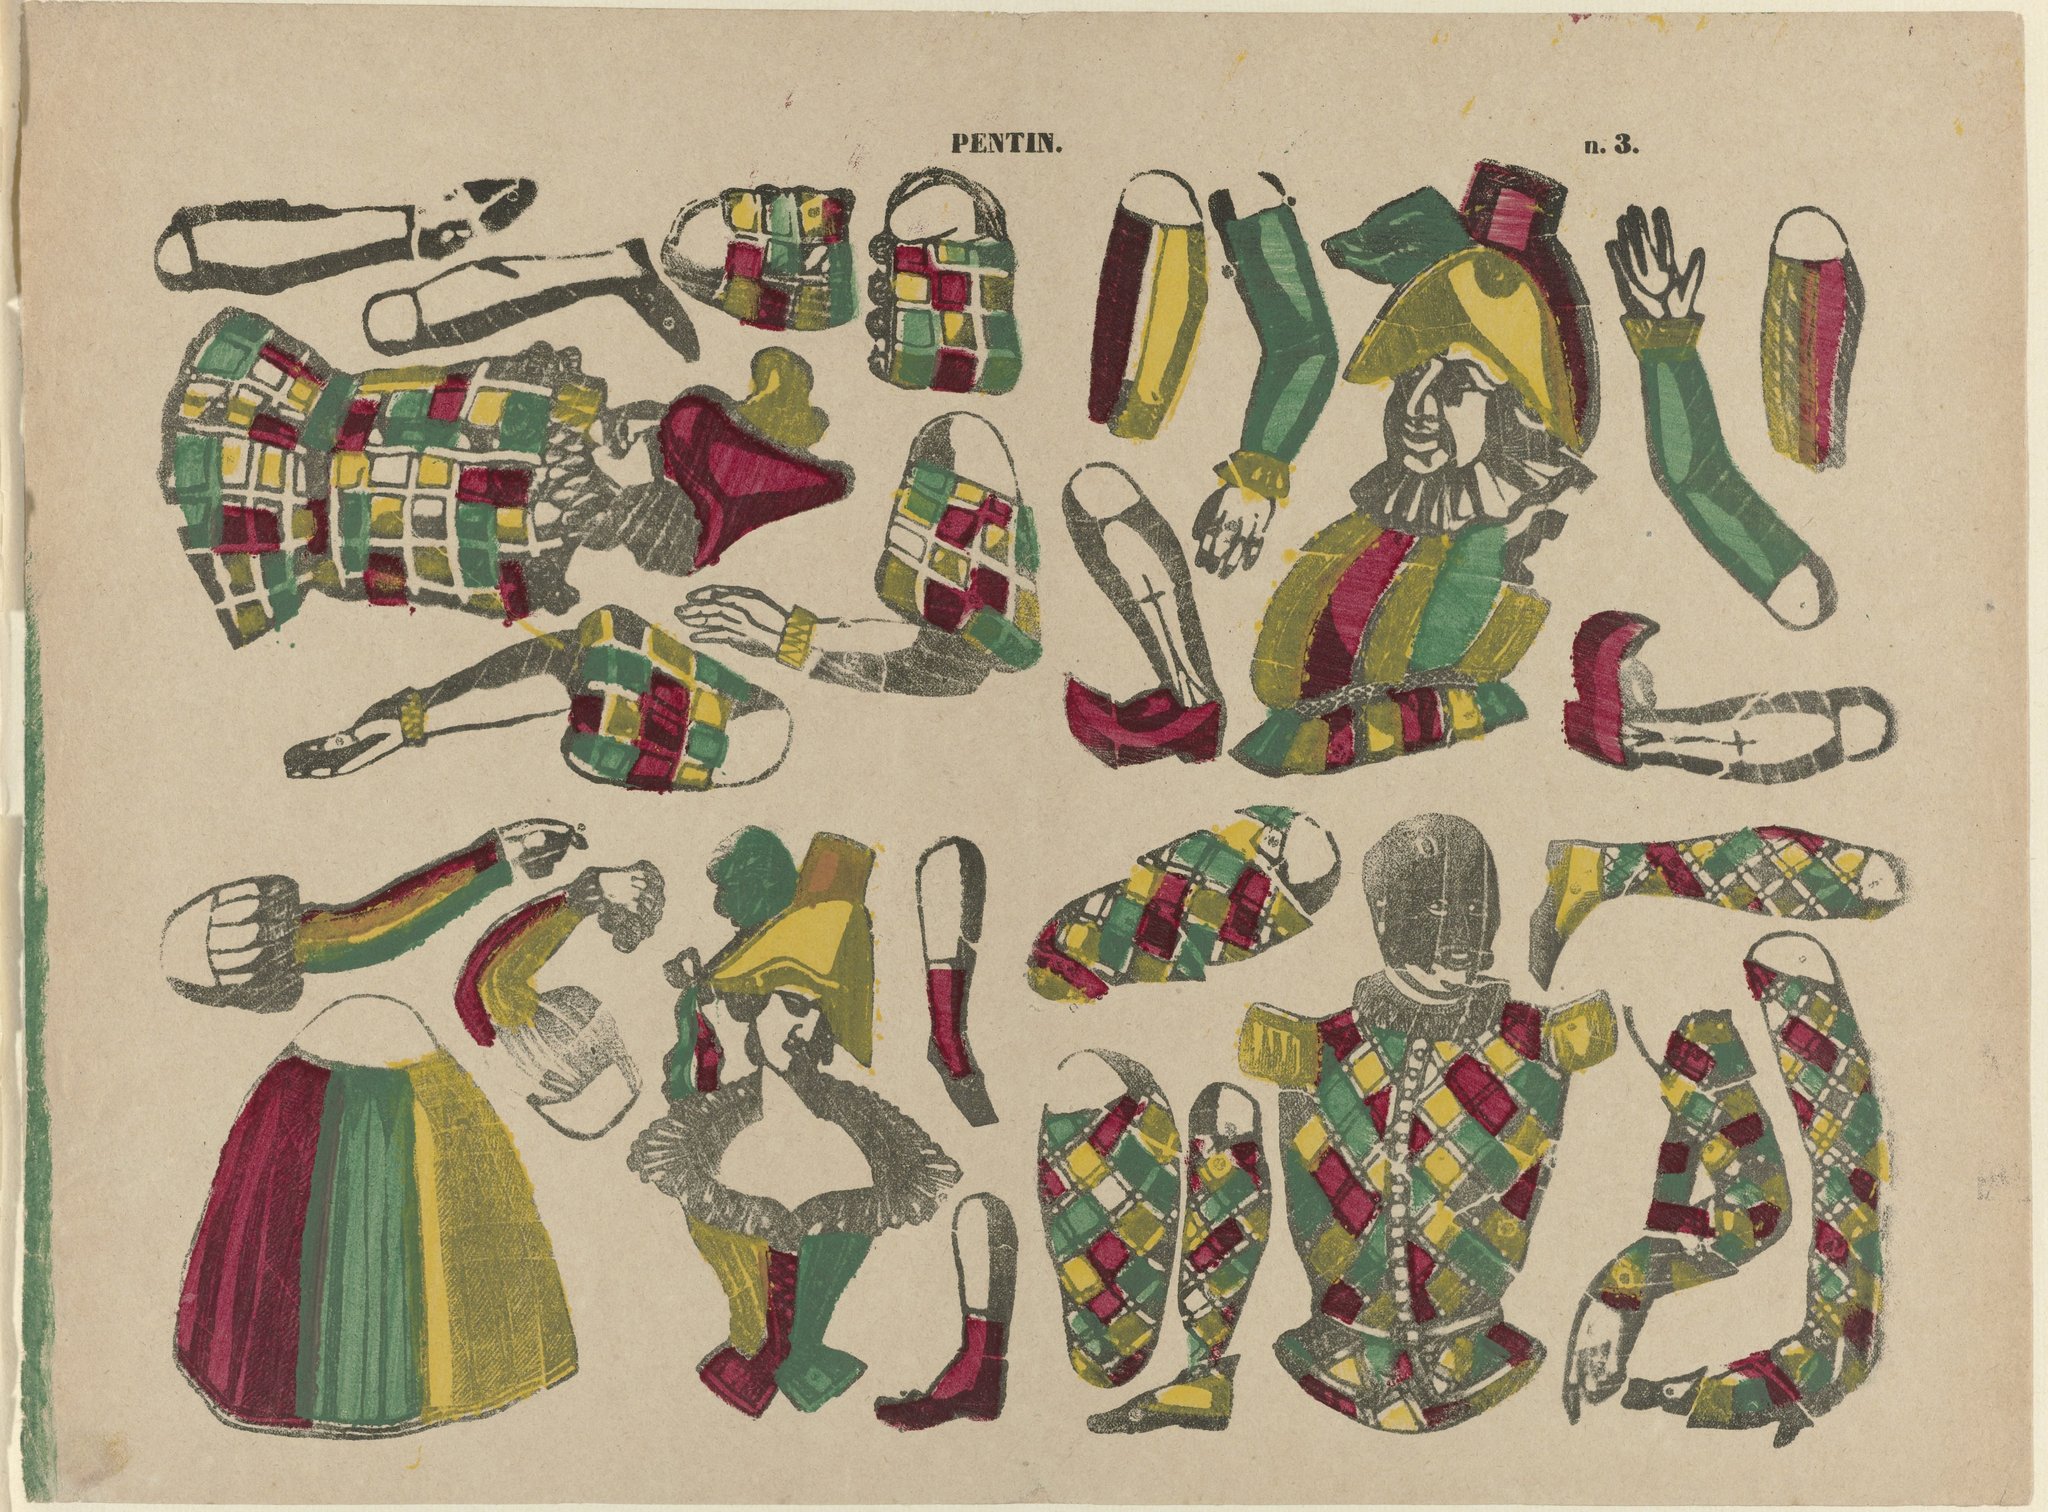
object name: pantin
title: Pentin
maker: Anonymous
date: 1856-1900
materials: paper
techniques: colour, letterpress printing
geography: turnhout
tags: puppet, types in 'commedia dell'arte': harlequin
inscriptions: collector's mark: Lugt 2760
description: Blad met 4 trekpoppen om uit te knippen. De vier poppen zijn personages uit de commedia dell'arte. Genummerd rechtsboven: n. 3.